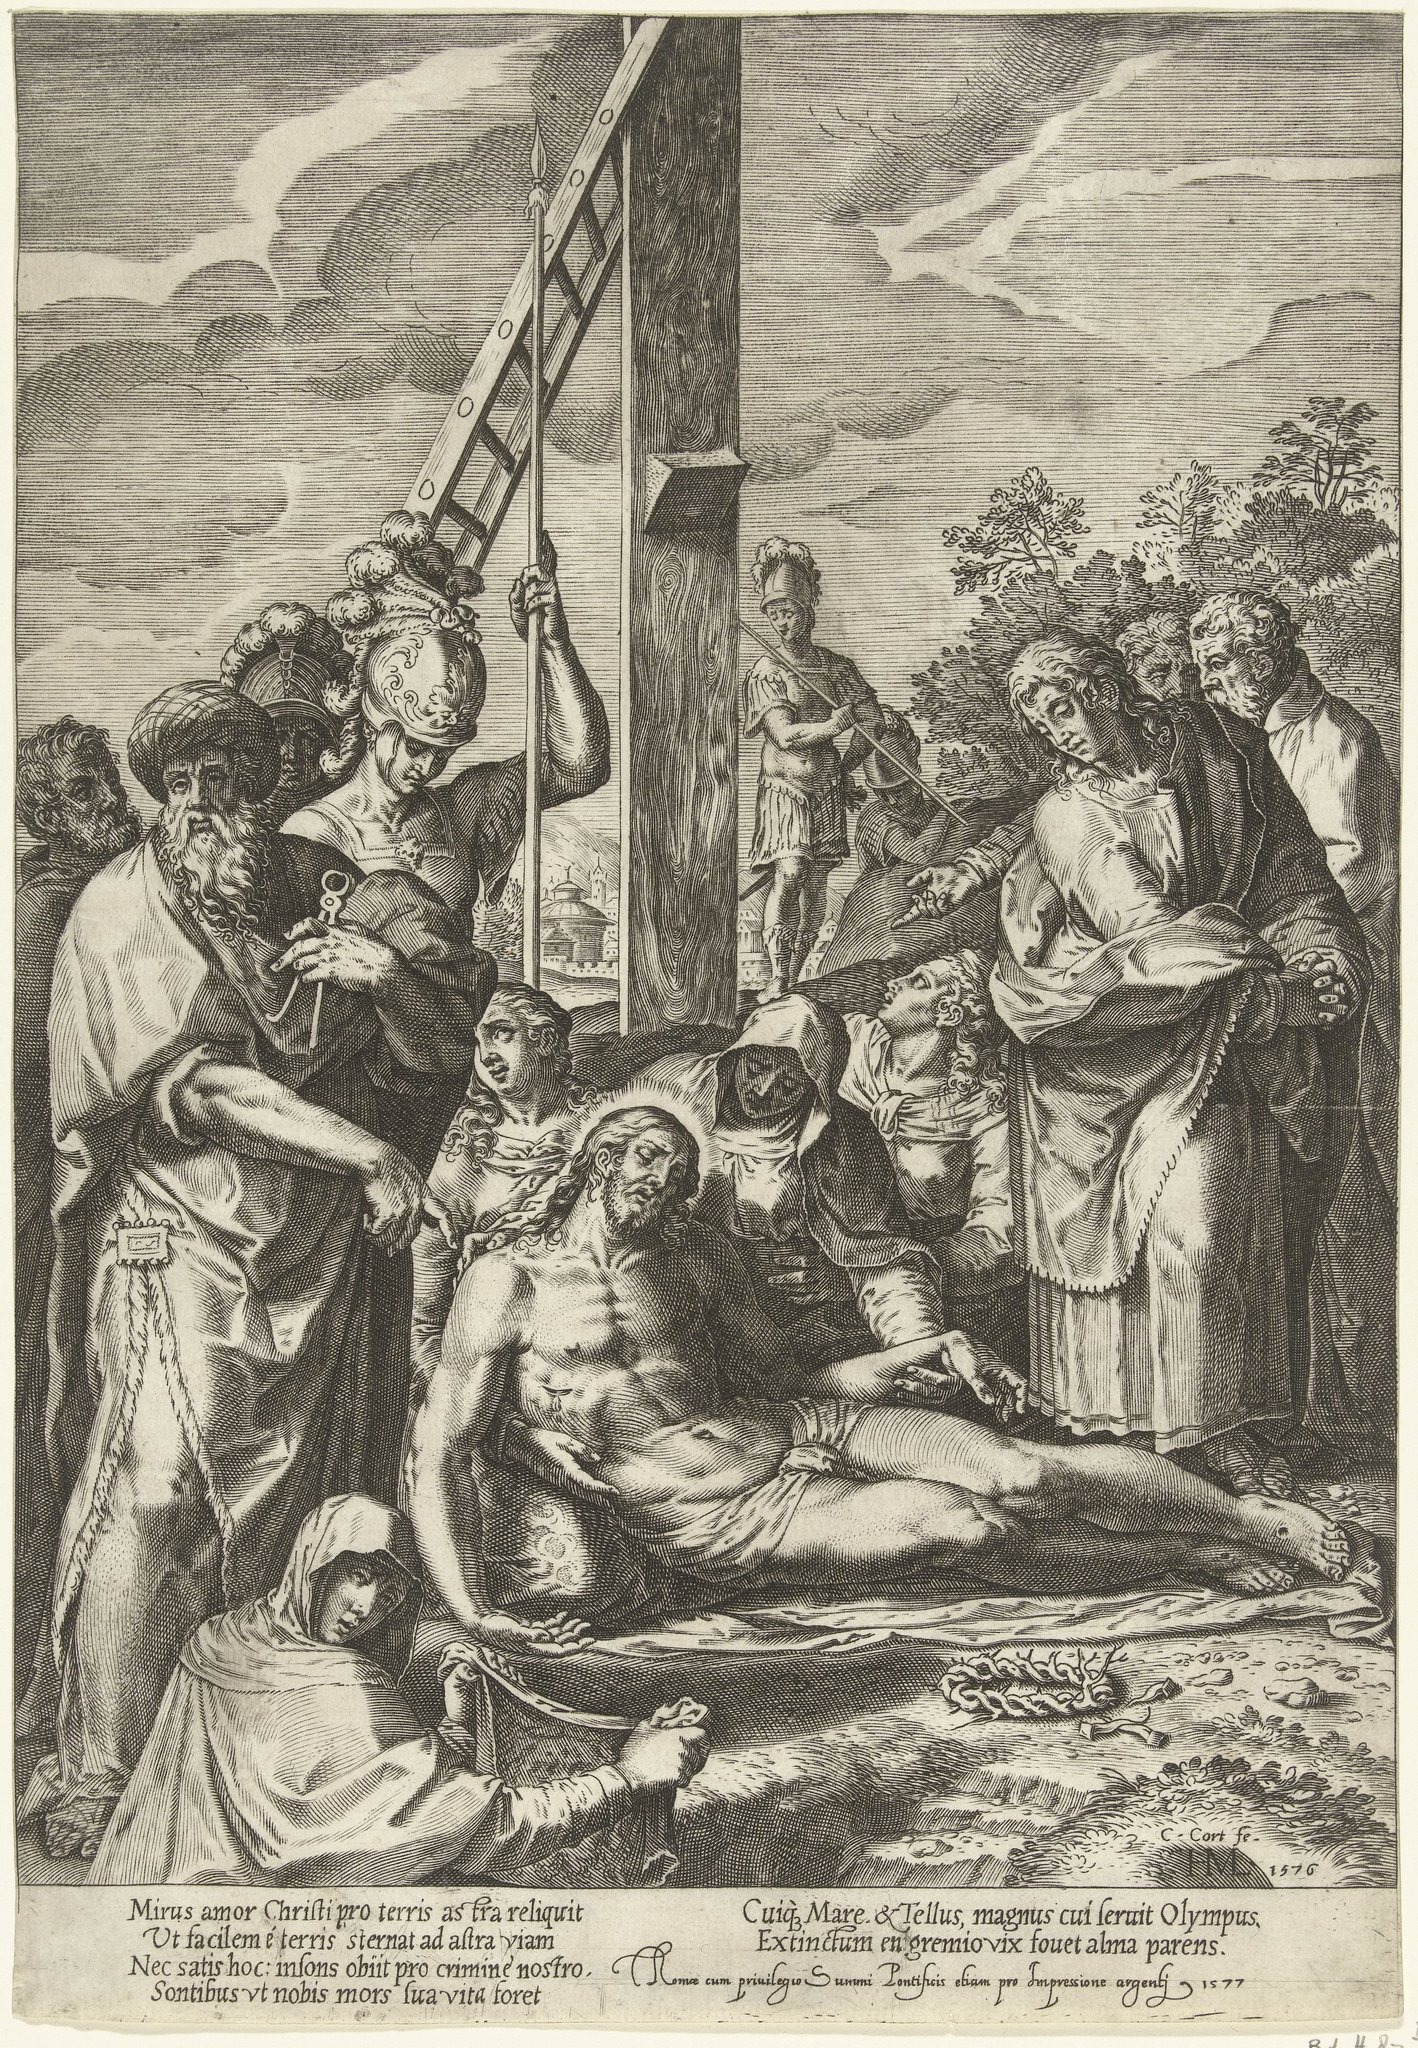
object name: print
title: Bewening van Christus onder het kruis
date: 1576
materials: paper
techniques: engraving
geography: rome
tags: lamentation over the dead christ by his relatives and friends (christ usually without crown of thorns)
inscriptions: caption: ‘Mirus amor Christi pro terris astra reliquit...magnus cui servit Olympus...Extinctum en gremio vix fovet alma parens’, date: ‘1576’, collector's mark: Lugt 2228, monogram: ‘HML’, signature: ‘C. Cort fec.’, privilege: ‘Romae cum privilegio Summi Pontificis etiam pro Impressione argenti 1577’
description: Christus aan de voet van het kruis, ondersteund door Maria. Naast haar staat Johannes de Doper. Op de voorgrond links Veronica met de zweetdoek in de handen. Achter haar Jozef van Arimathea en soldaten.